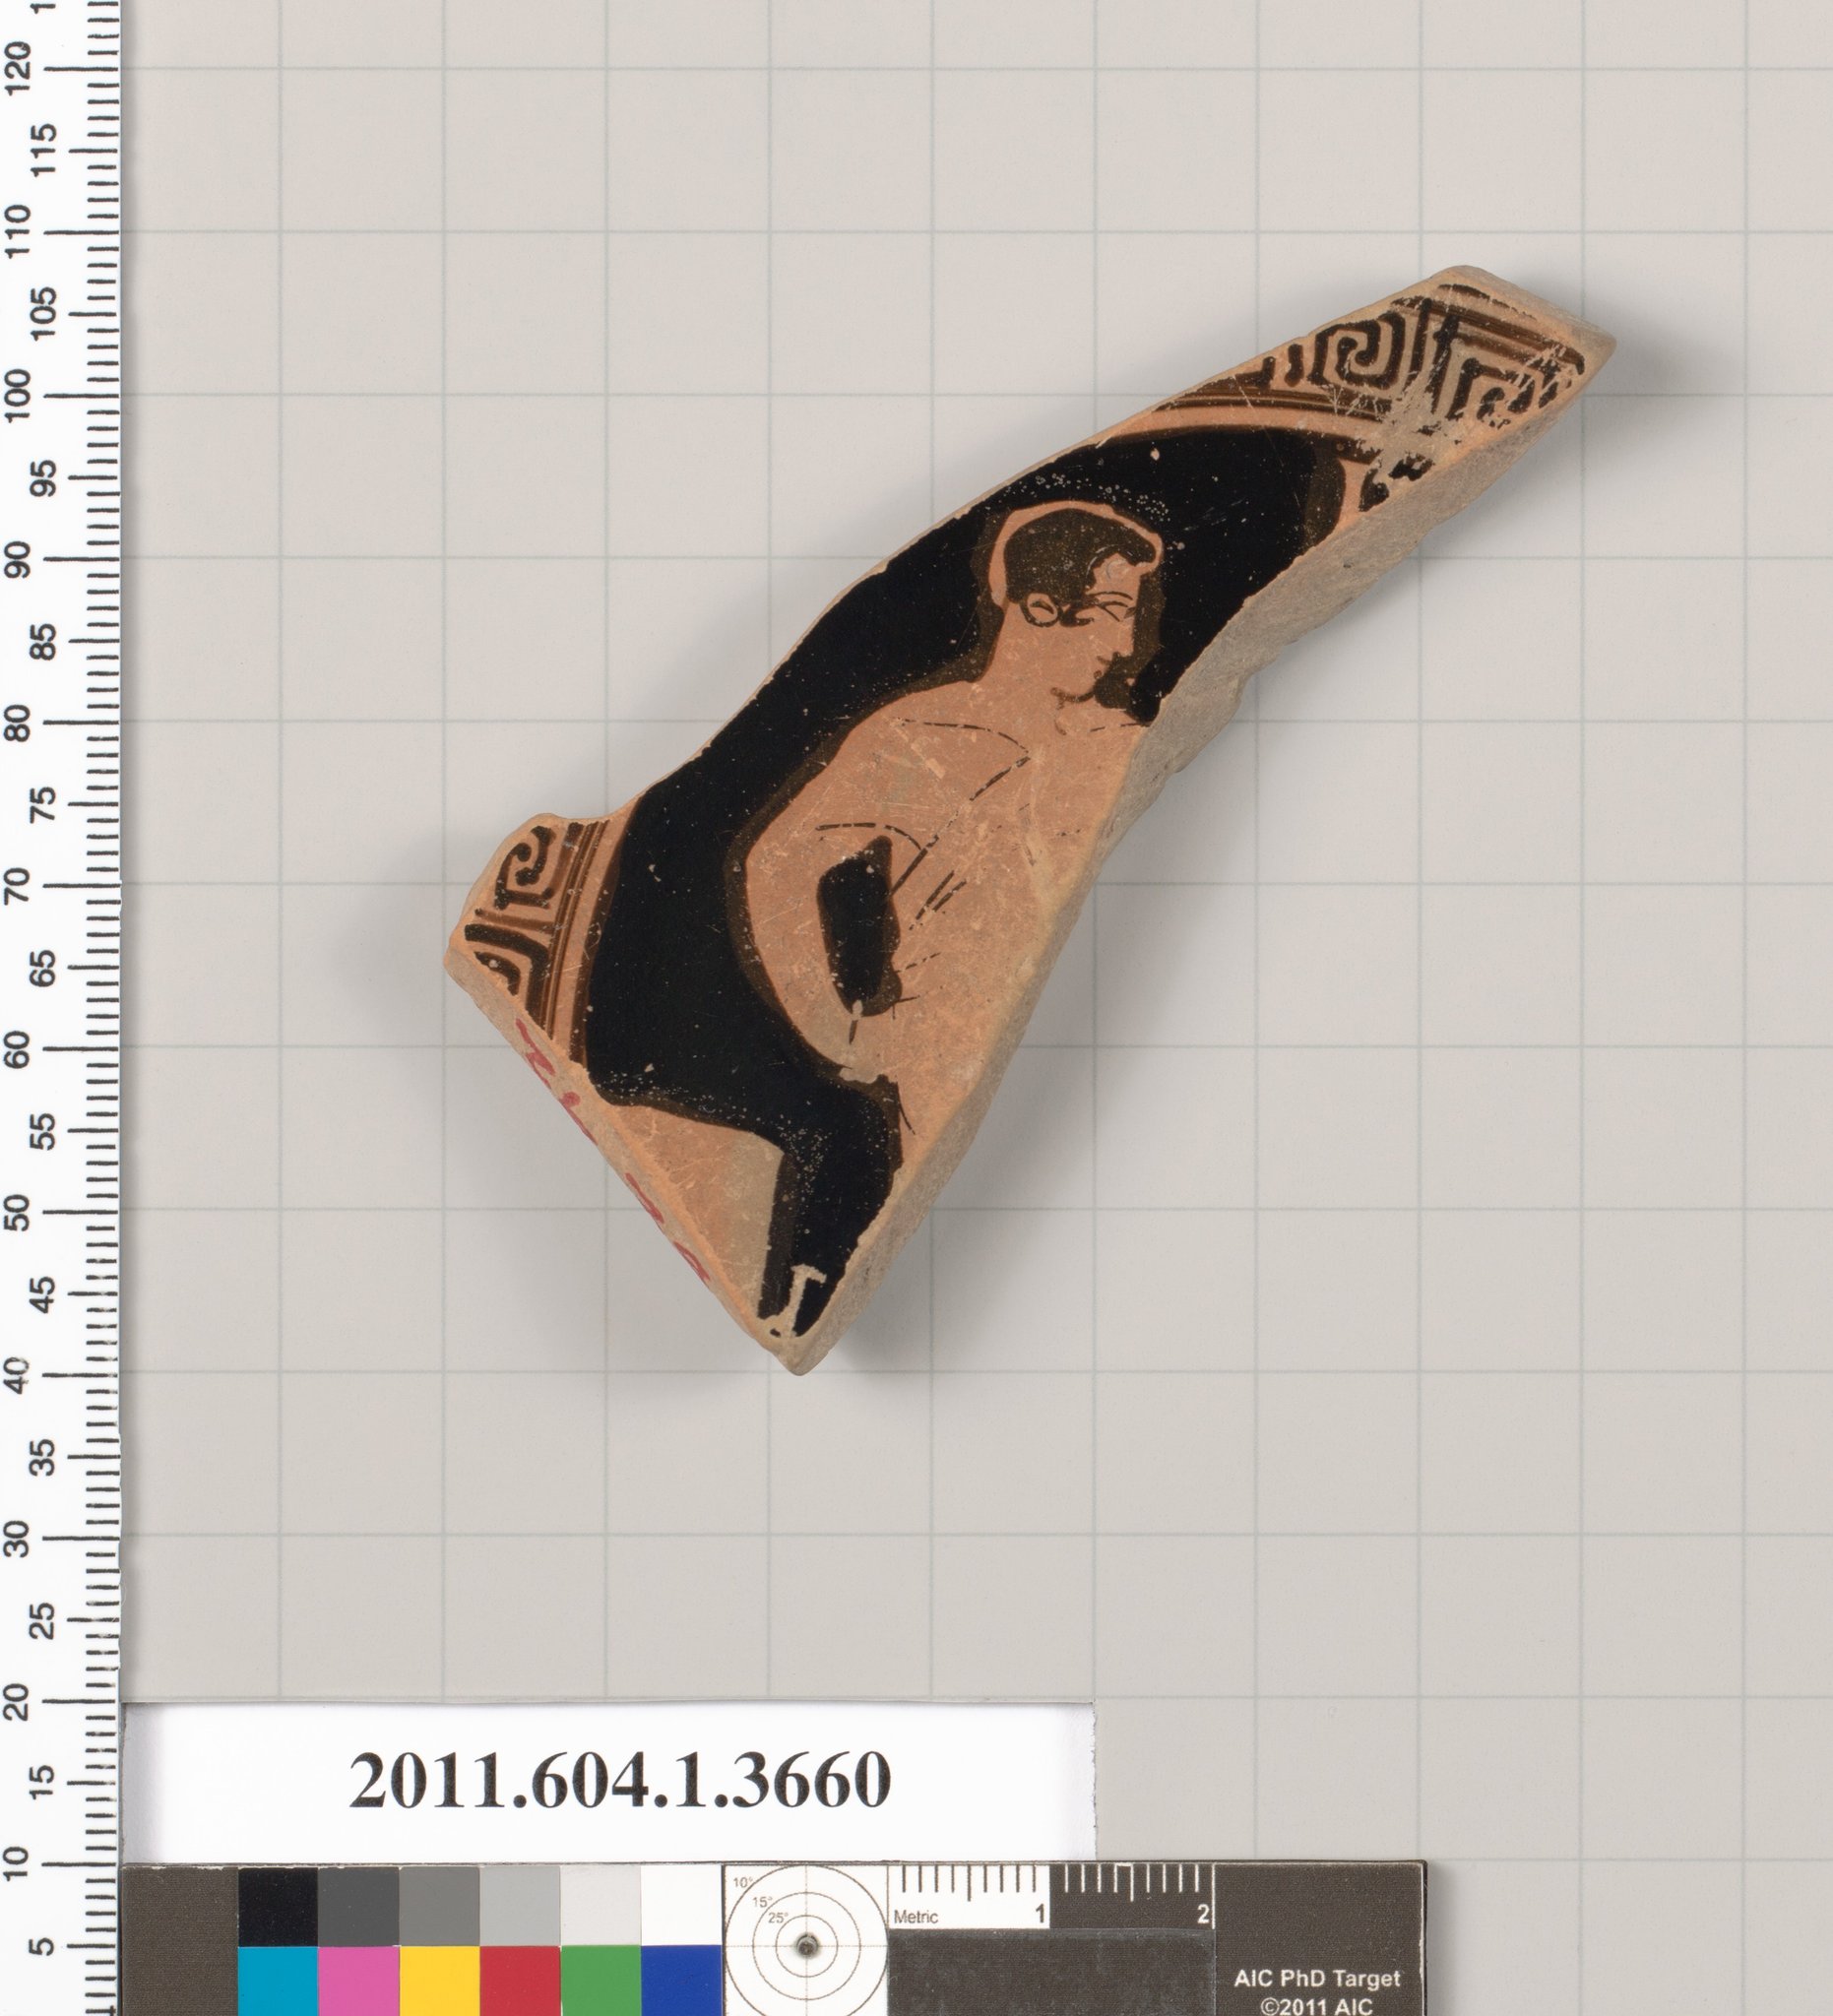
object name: kylix fragment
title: Terracotta fragment of a kylix (drinking cup)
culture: greek, attic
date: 467-435 BCE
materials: terracotta